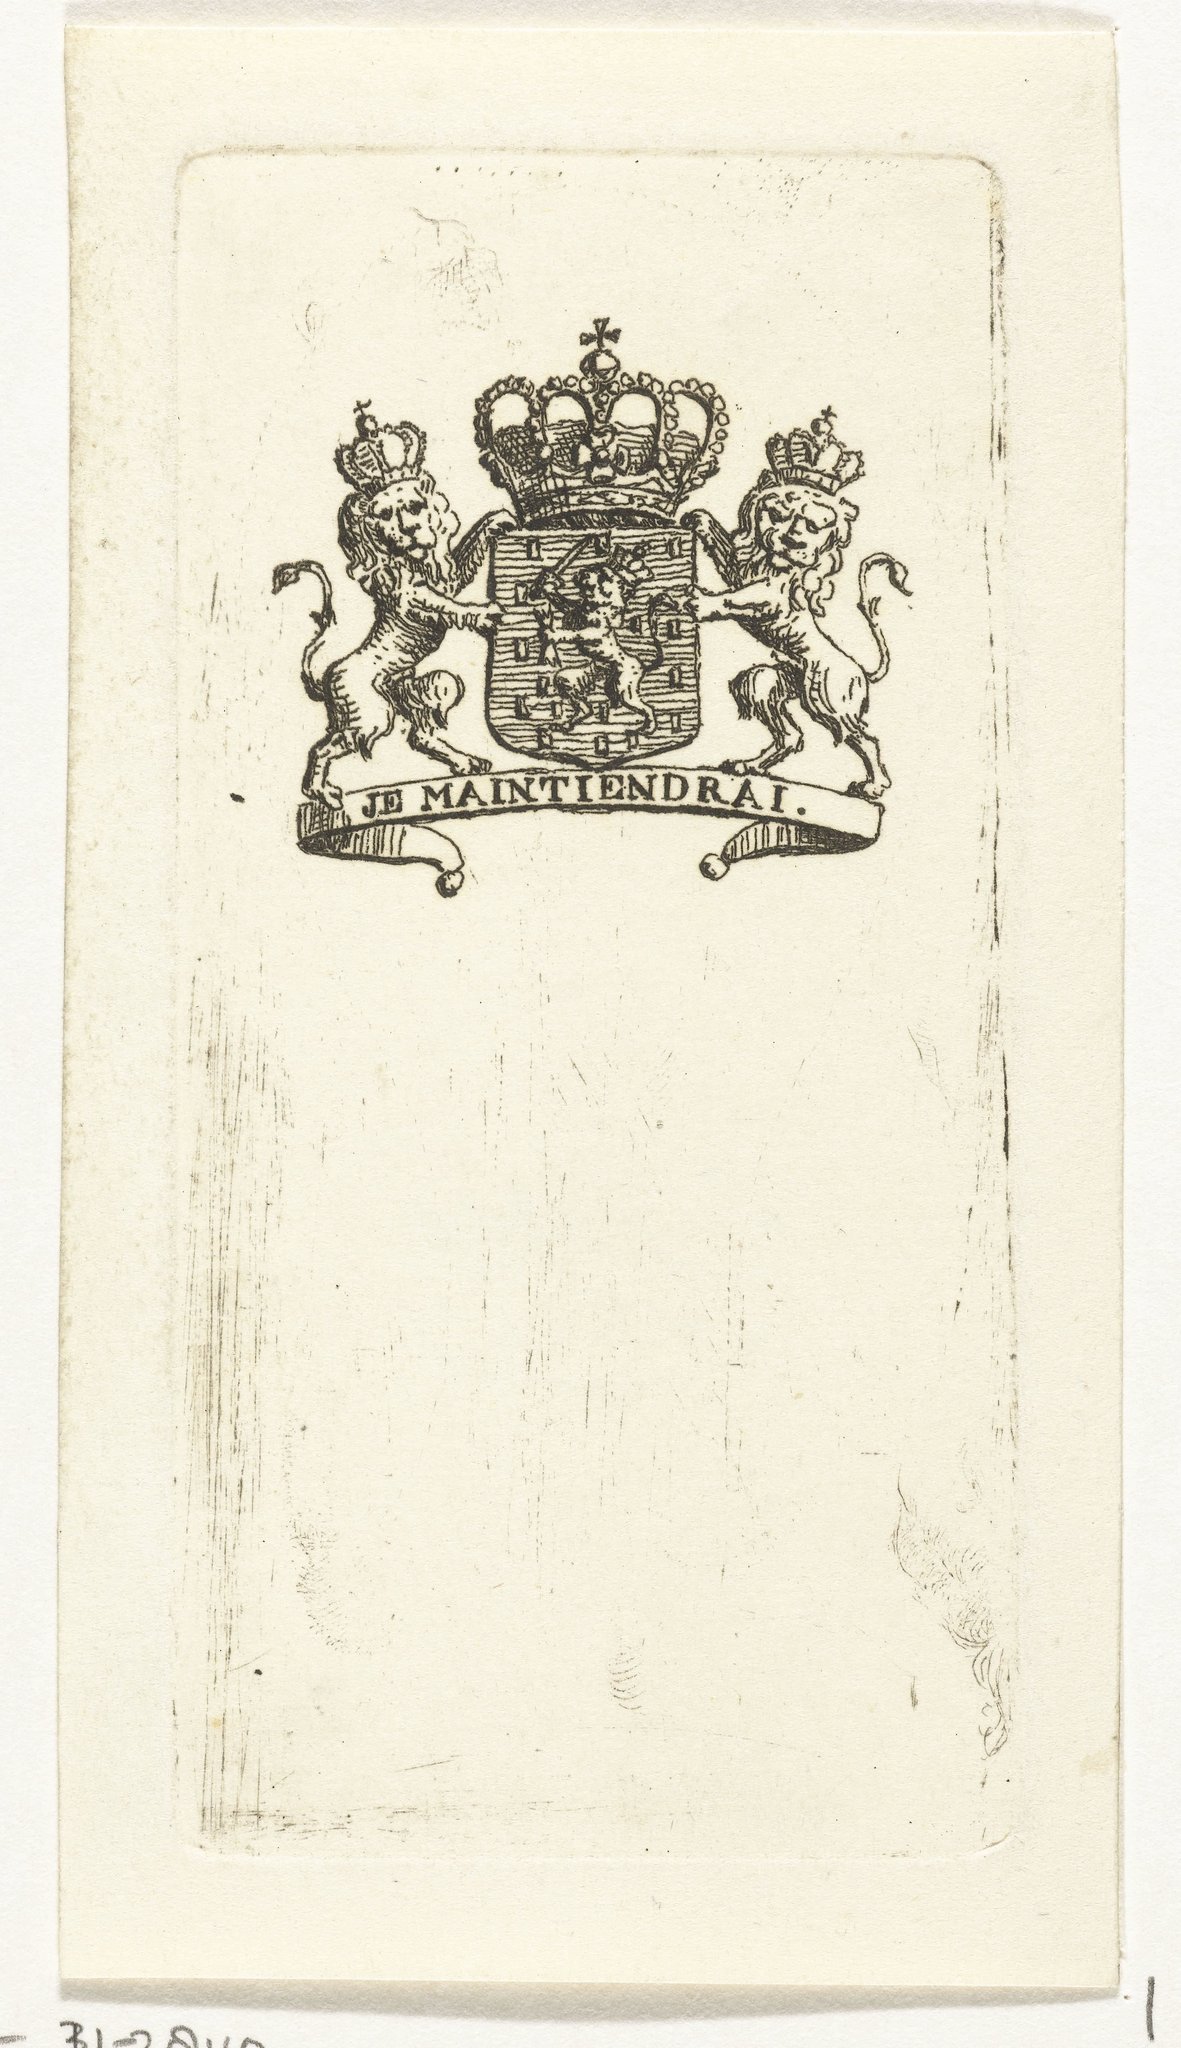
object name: print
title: Vignet met wapen van Nederland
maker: anthonie van den bos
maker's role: draughtsman, print maker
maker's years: 1763-1838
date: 1778-1838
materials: paper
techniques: etching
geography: netherlands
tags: armorial bearing, heraldry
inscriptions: collector's mark: Lugt 2228